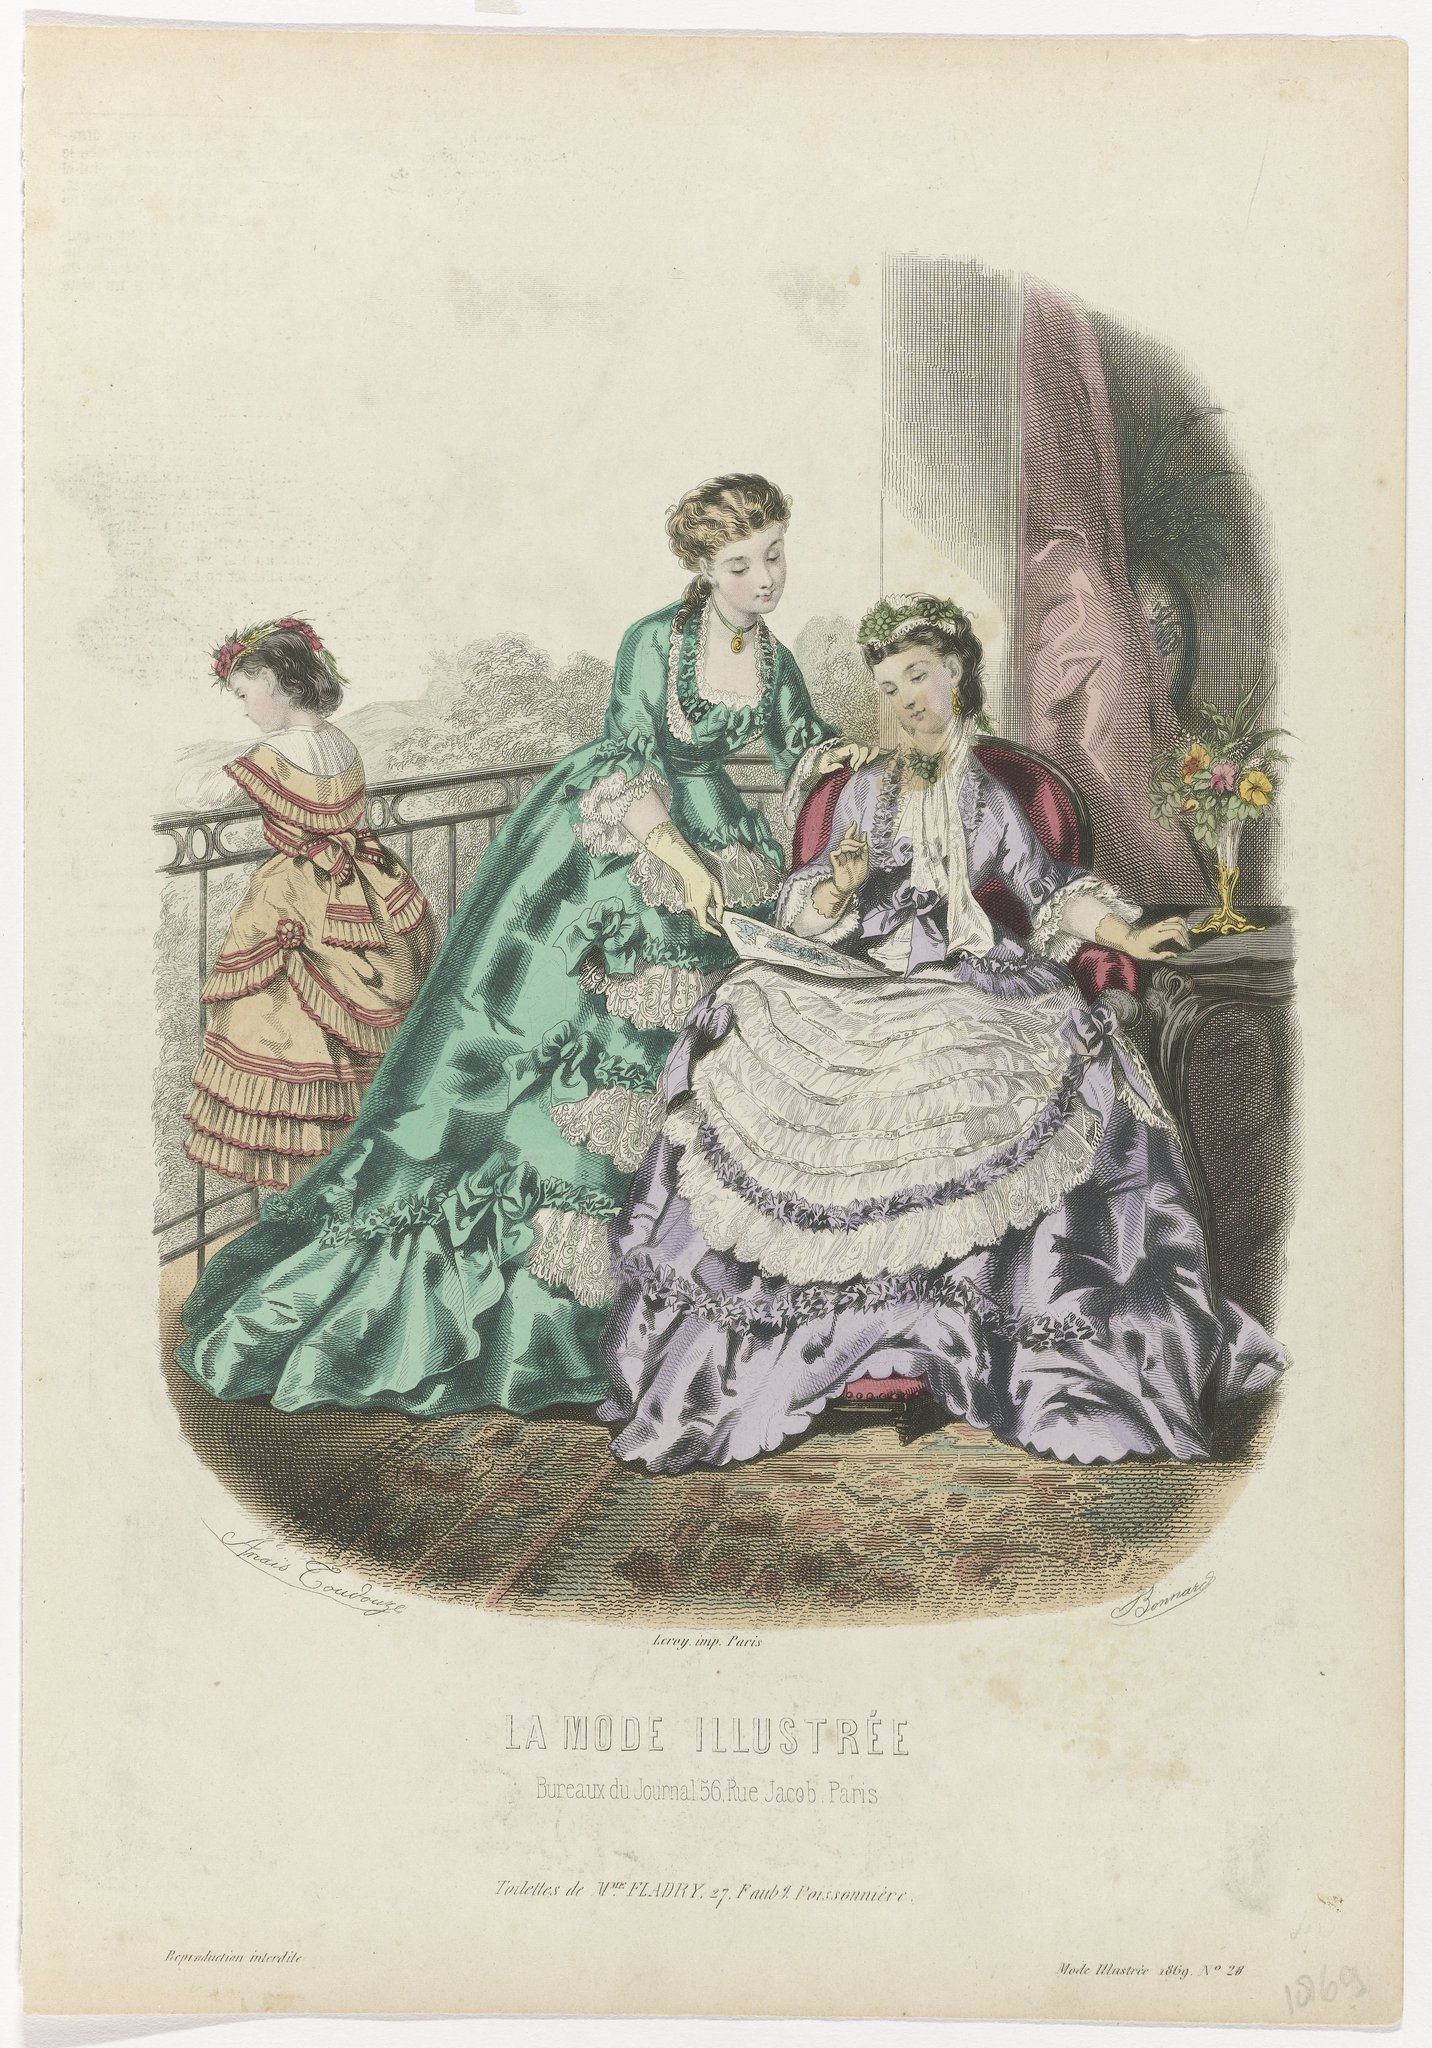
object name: fashion print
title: La Mode Illustrée, 1869, No. 28: Toilettes de Mme Fladry (...)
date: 1869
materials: paper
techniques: engraving, hand coloring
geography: paris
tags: ear-rings (+ women's clothes), pendant, trinket, 'breloque' (+ women's clothes), head-gear (+ girls' clothes), head-gear (+ women's clothes), fashion plates, gloves, mittens, etc. (+ women's clothes), dress, gown (+ women's clothes), dress, gown (+ girls' clothes)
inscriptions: caption: ‘Toilettes de M.me Fladry, 27, Faub g Poissonnière.’, address: ‘Bureaux du Journal, 56, Rue Jacob. Paris’, title: ‘La Mode Illustrée’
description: Twee vrouwen en een meisje bij een balustrade. Volgens het onderschrift: 'toilettes' van Fladry. Prent uit het modetijdschrift La Mode Illustrée (1860-1937).